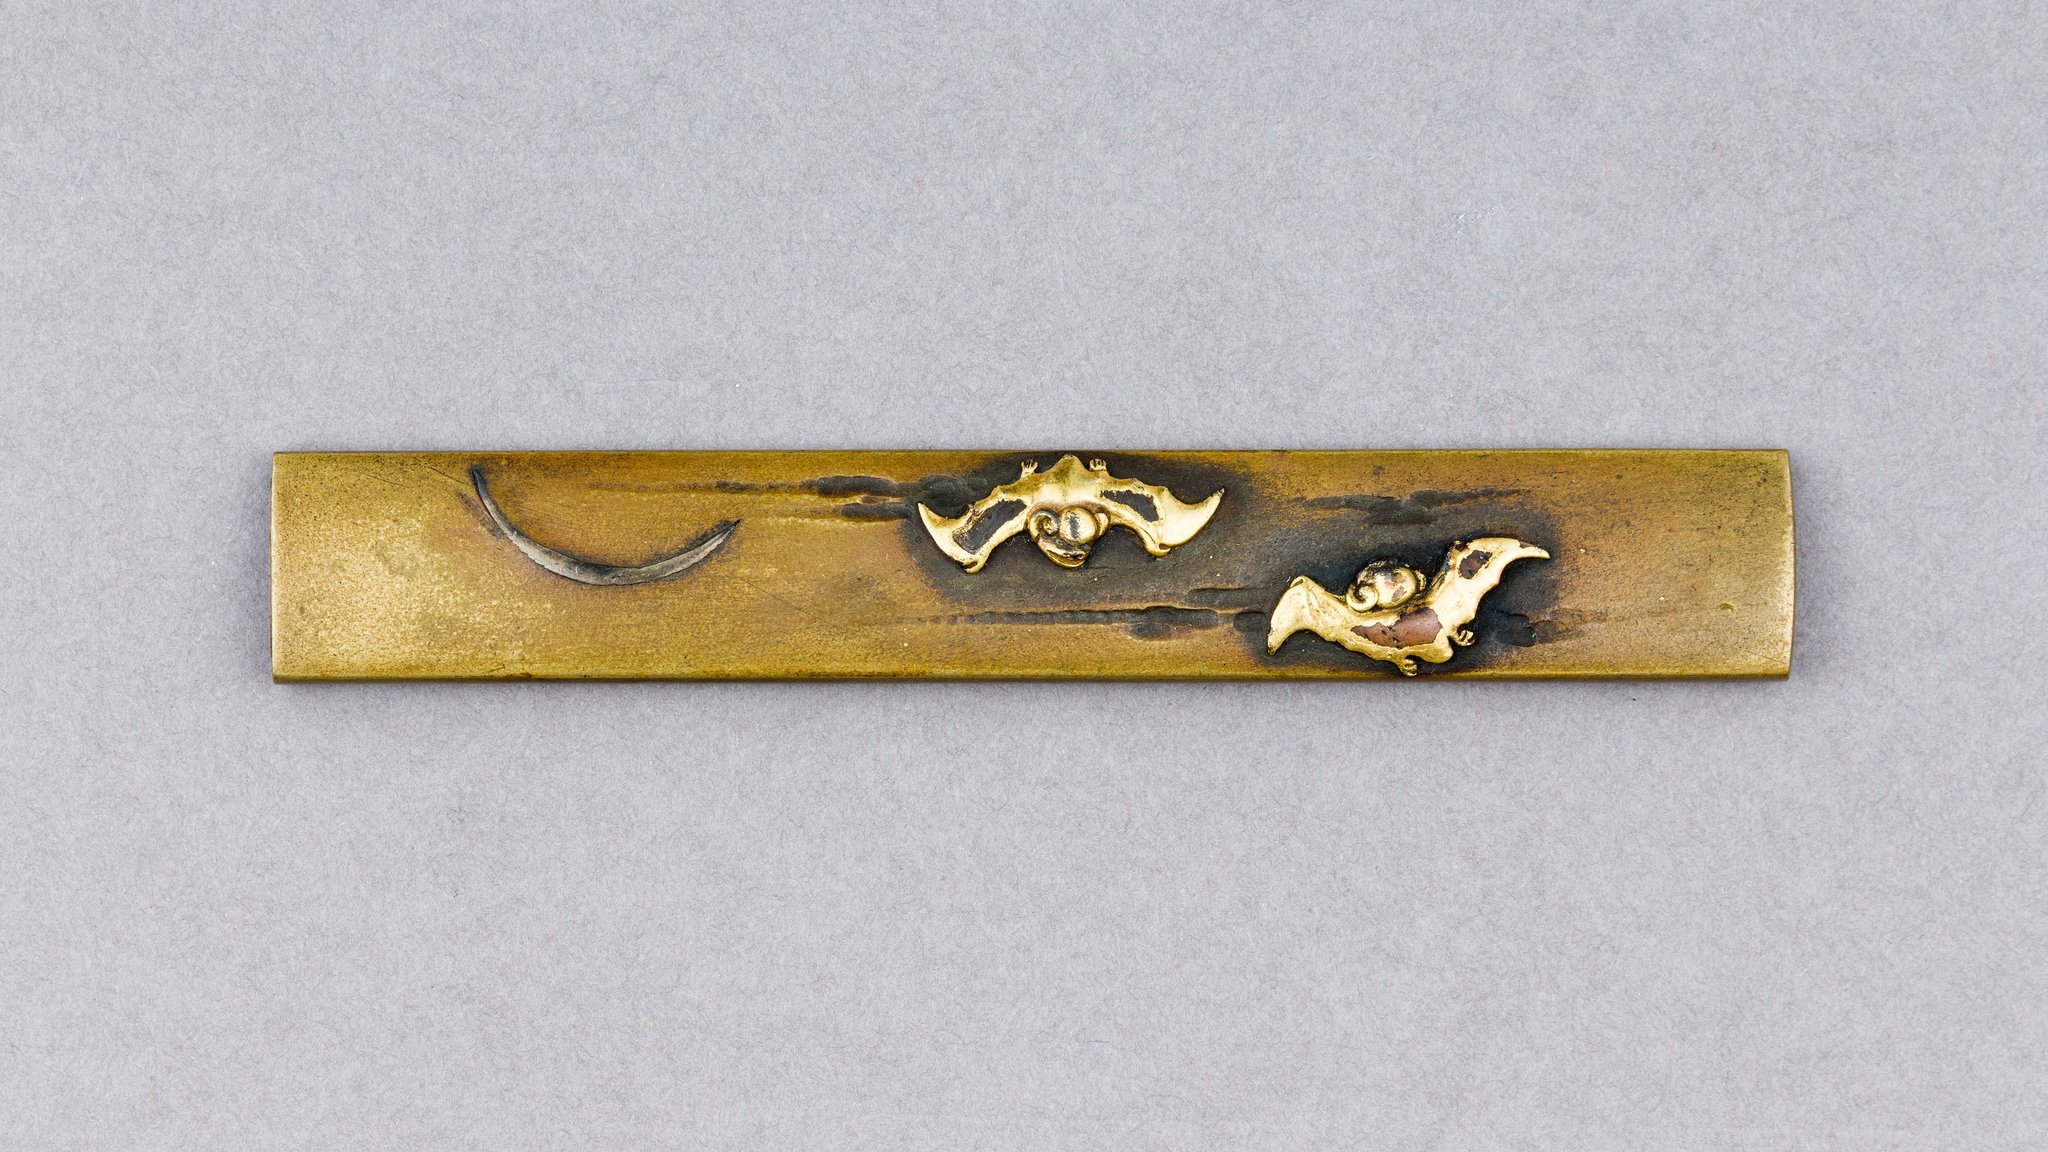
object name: knife handle kozuka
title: Knife Handle (Kozuka)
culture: japanese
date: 1615-1868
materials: copper, copper alloy, gold alloy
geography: japan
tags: bats